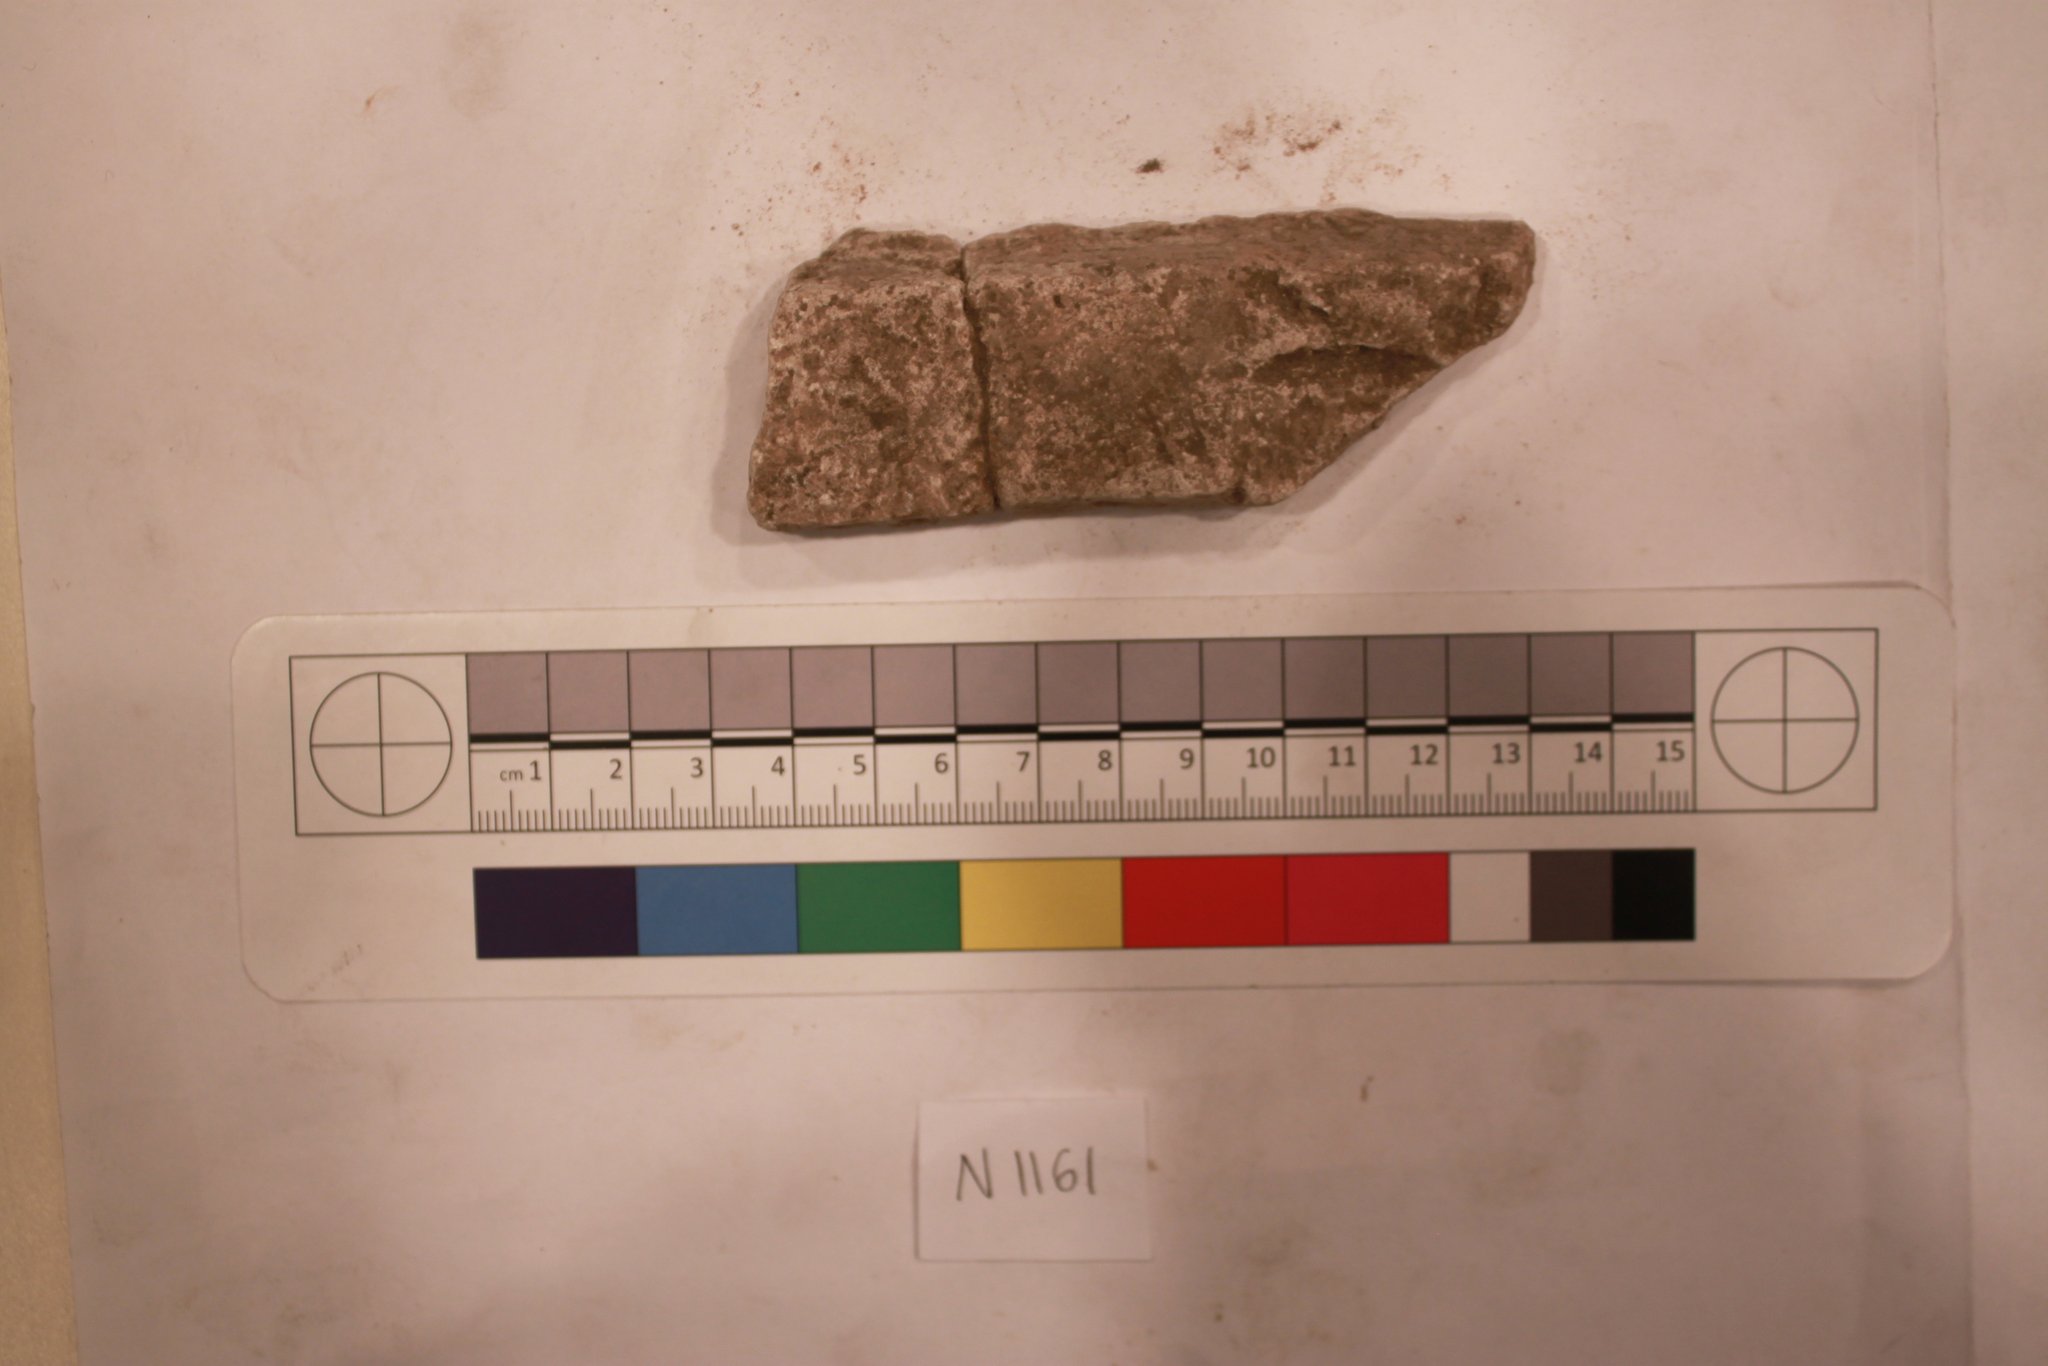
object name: fragment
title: Stucco Fragment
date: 701-1200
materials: plaster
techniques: carving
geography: iran